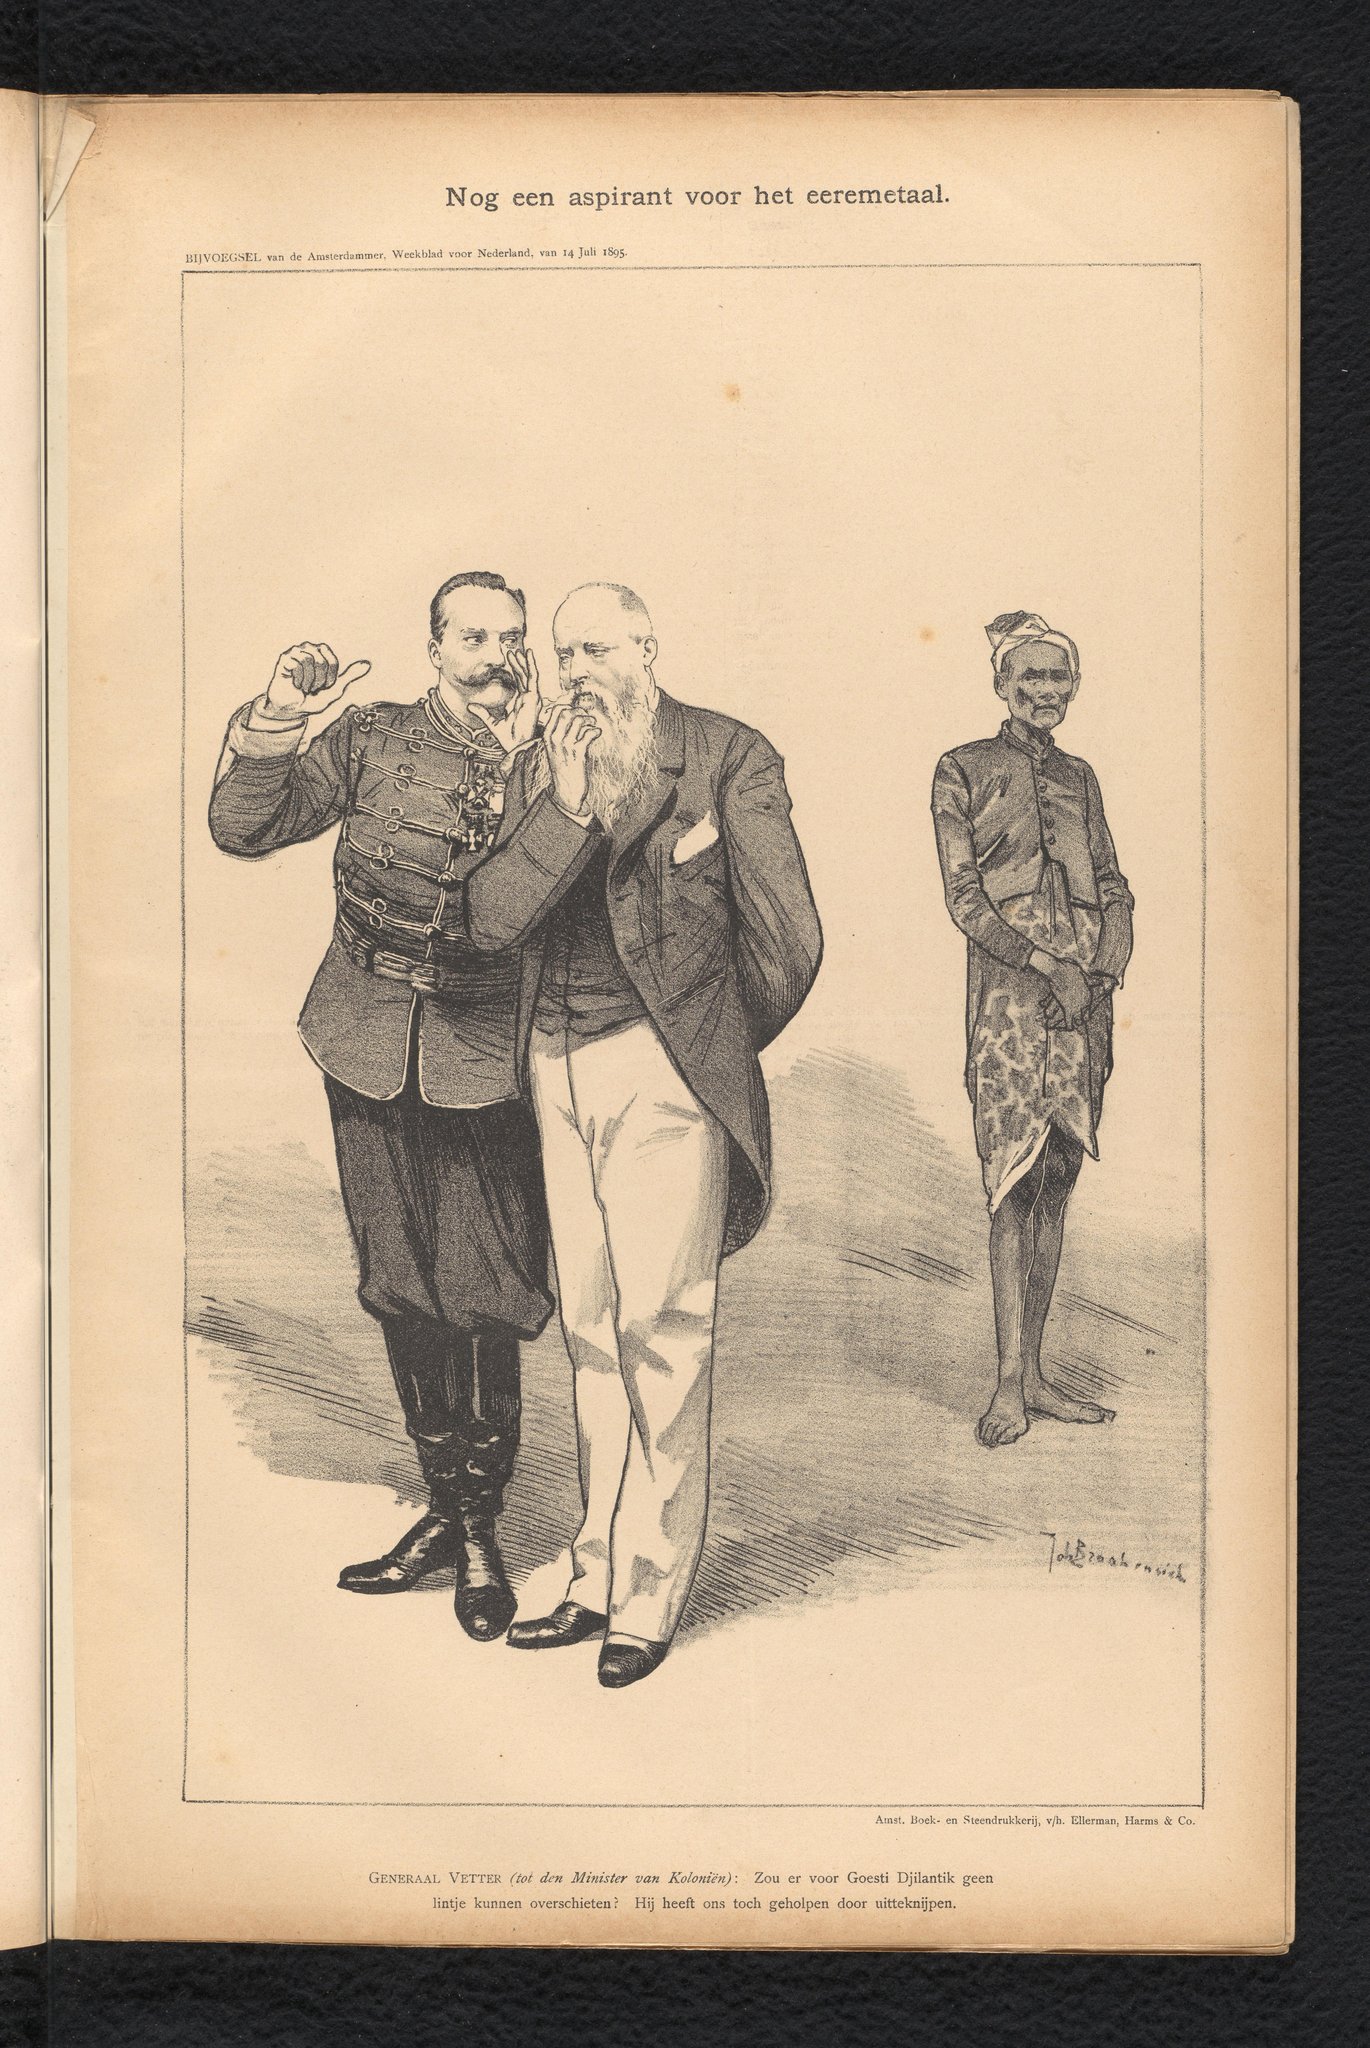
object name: cartoon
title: Nog een aspirant voor het eeremetaal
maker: johan braakensiek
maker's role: draughtsman, print maker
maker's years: 1858-1940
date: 1895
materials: paper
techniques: lithograph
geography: amsterdam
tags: utrecht, the hague, politician, political caricatures and satires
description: Generaal Vetter vraagt aan de minister van Koloniën Bergsma of er niet een medaille is voor Gusti Gde Djelantik, prins van Lombok.